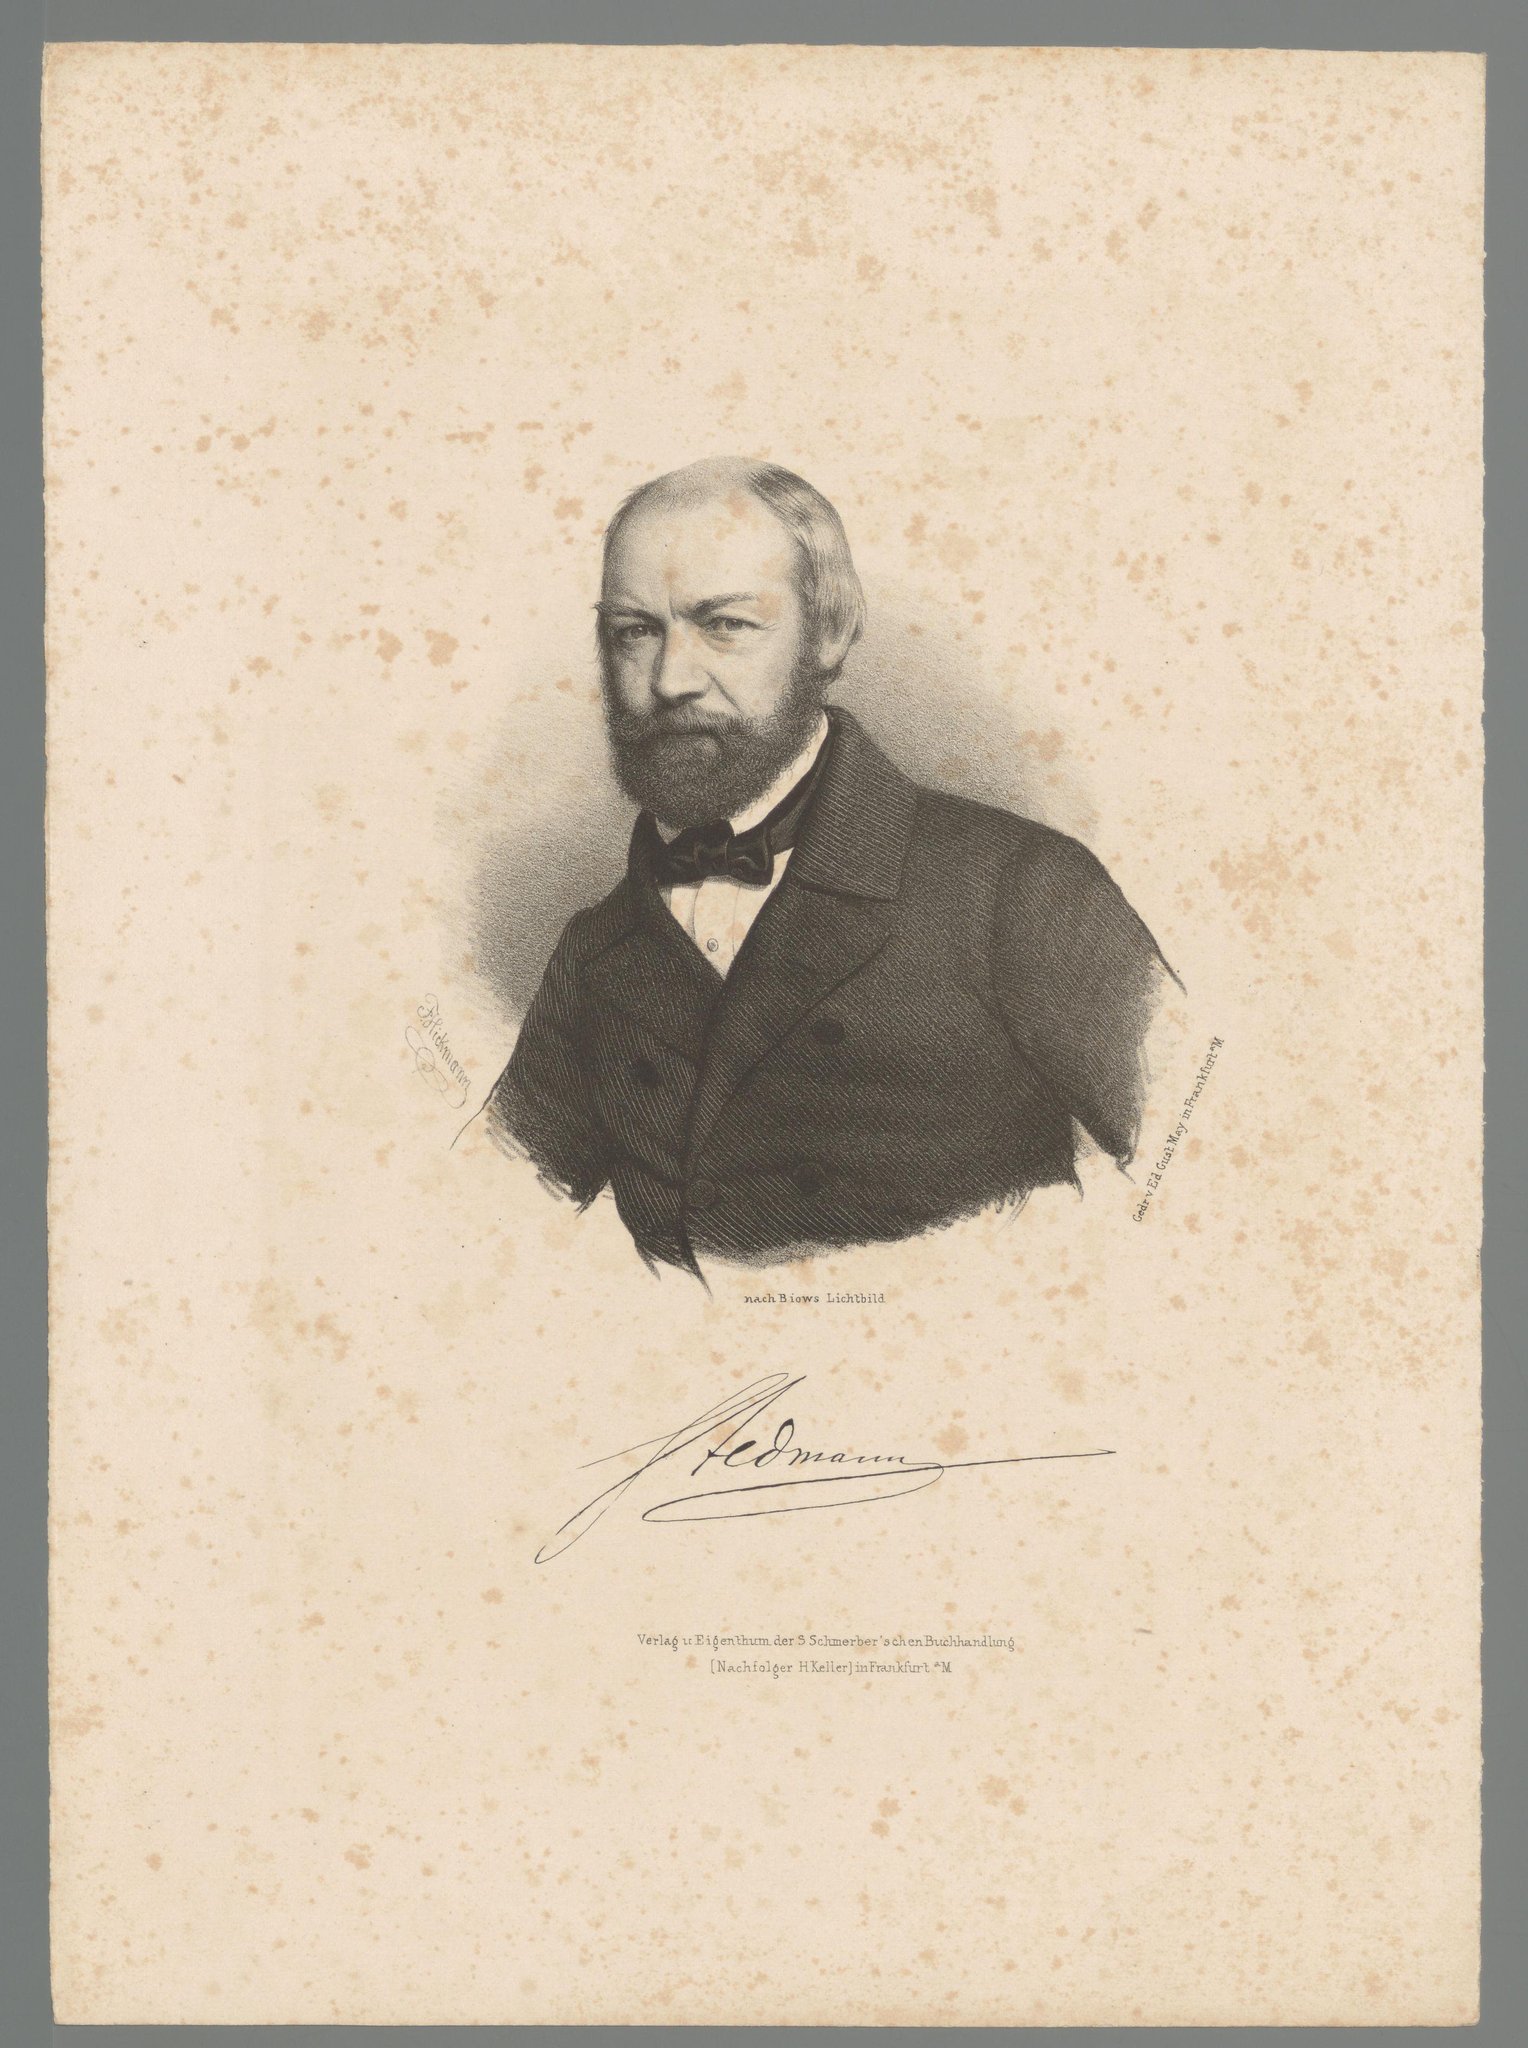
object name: print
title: Portret van Karl von Stedman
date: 1840-1900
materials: paper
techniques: lithograph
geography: frankfurt am main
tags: politician, historical persons, politician, e.g. party leader, officer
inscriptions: collector's mark: Lugt 2228